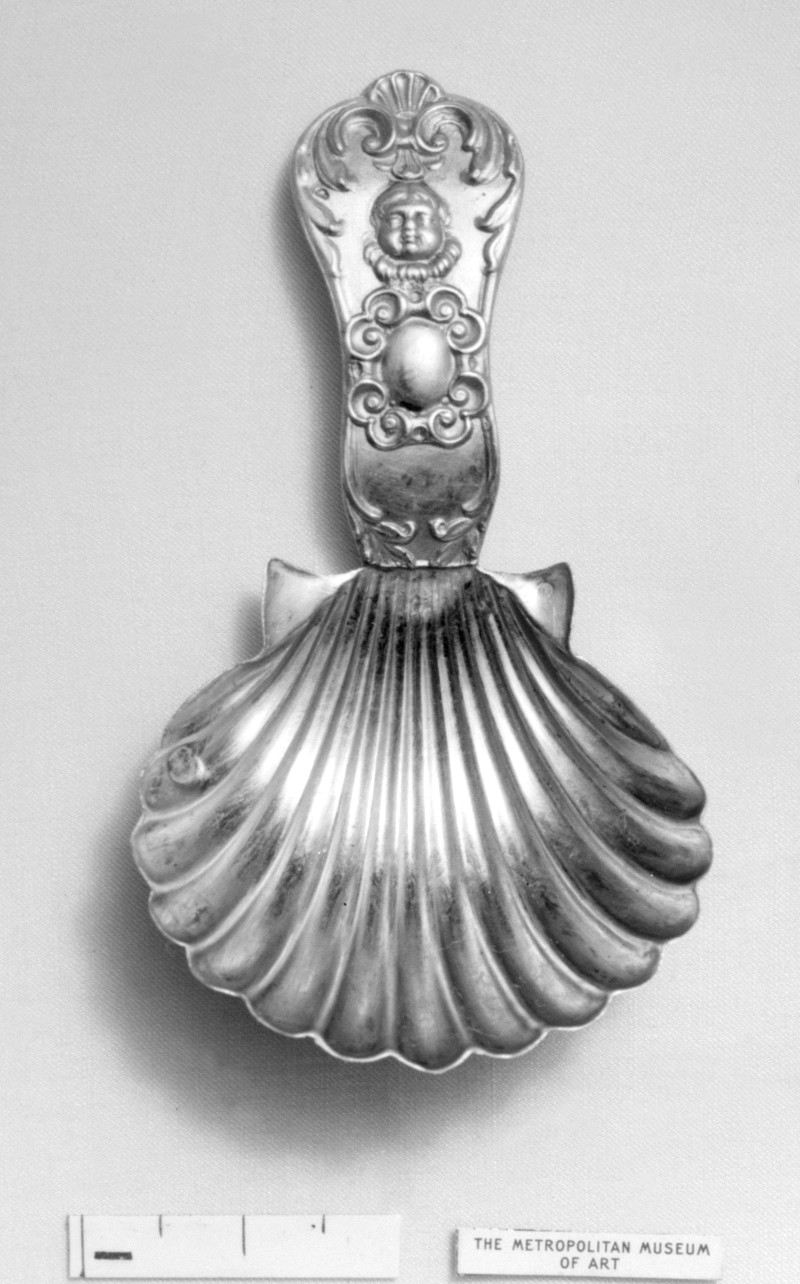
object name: caddy spoon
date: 1801-1833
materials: silver